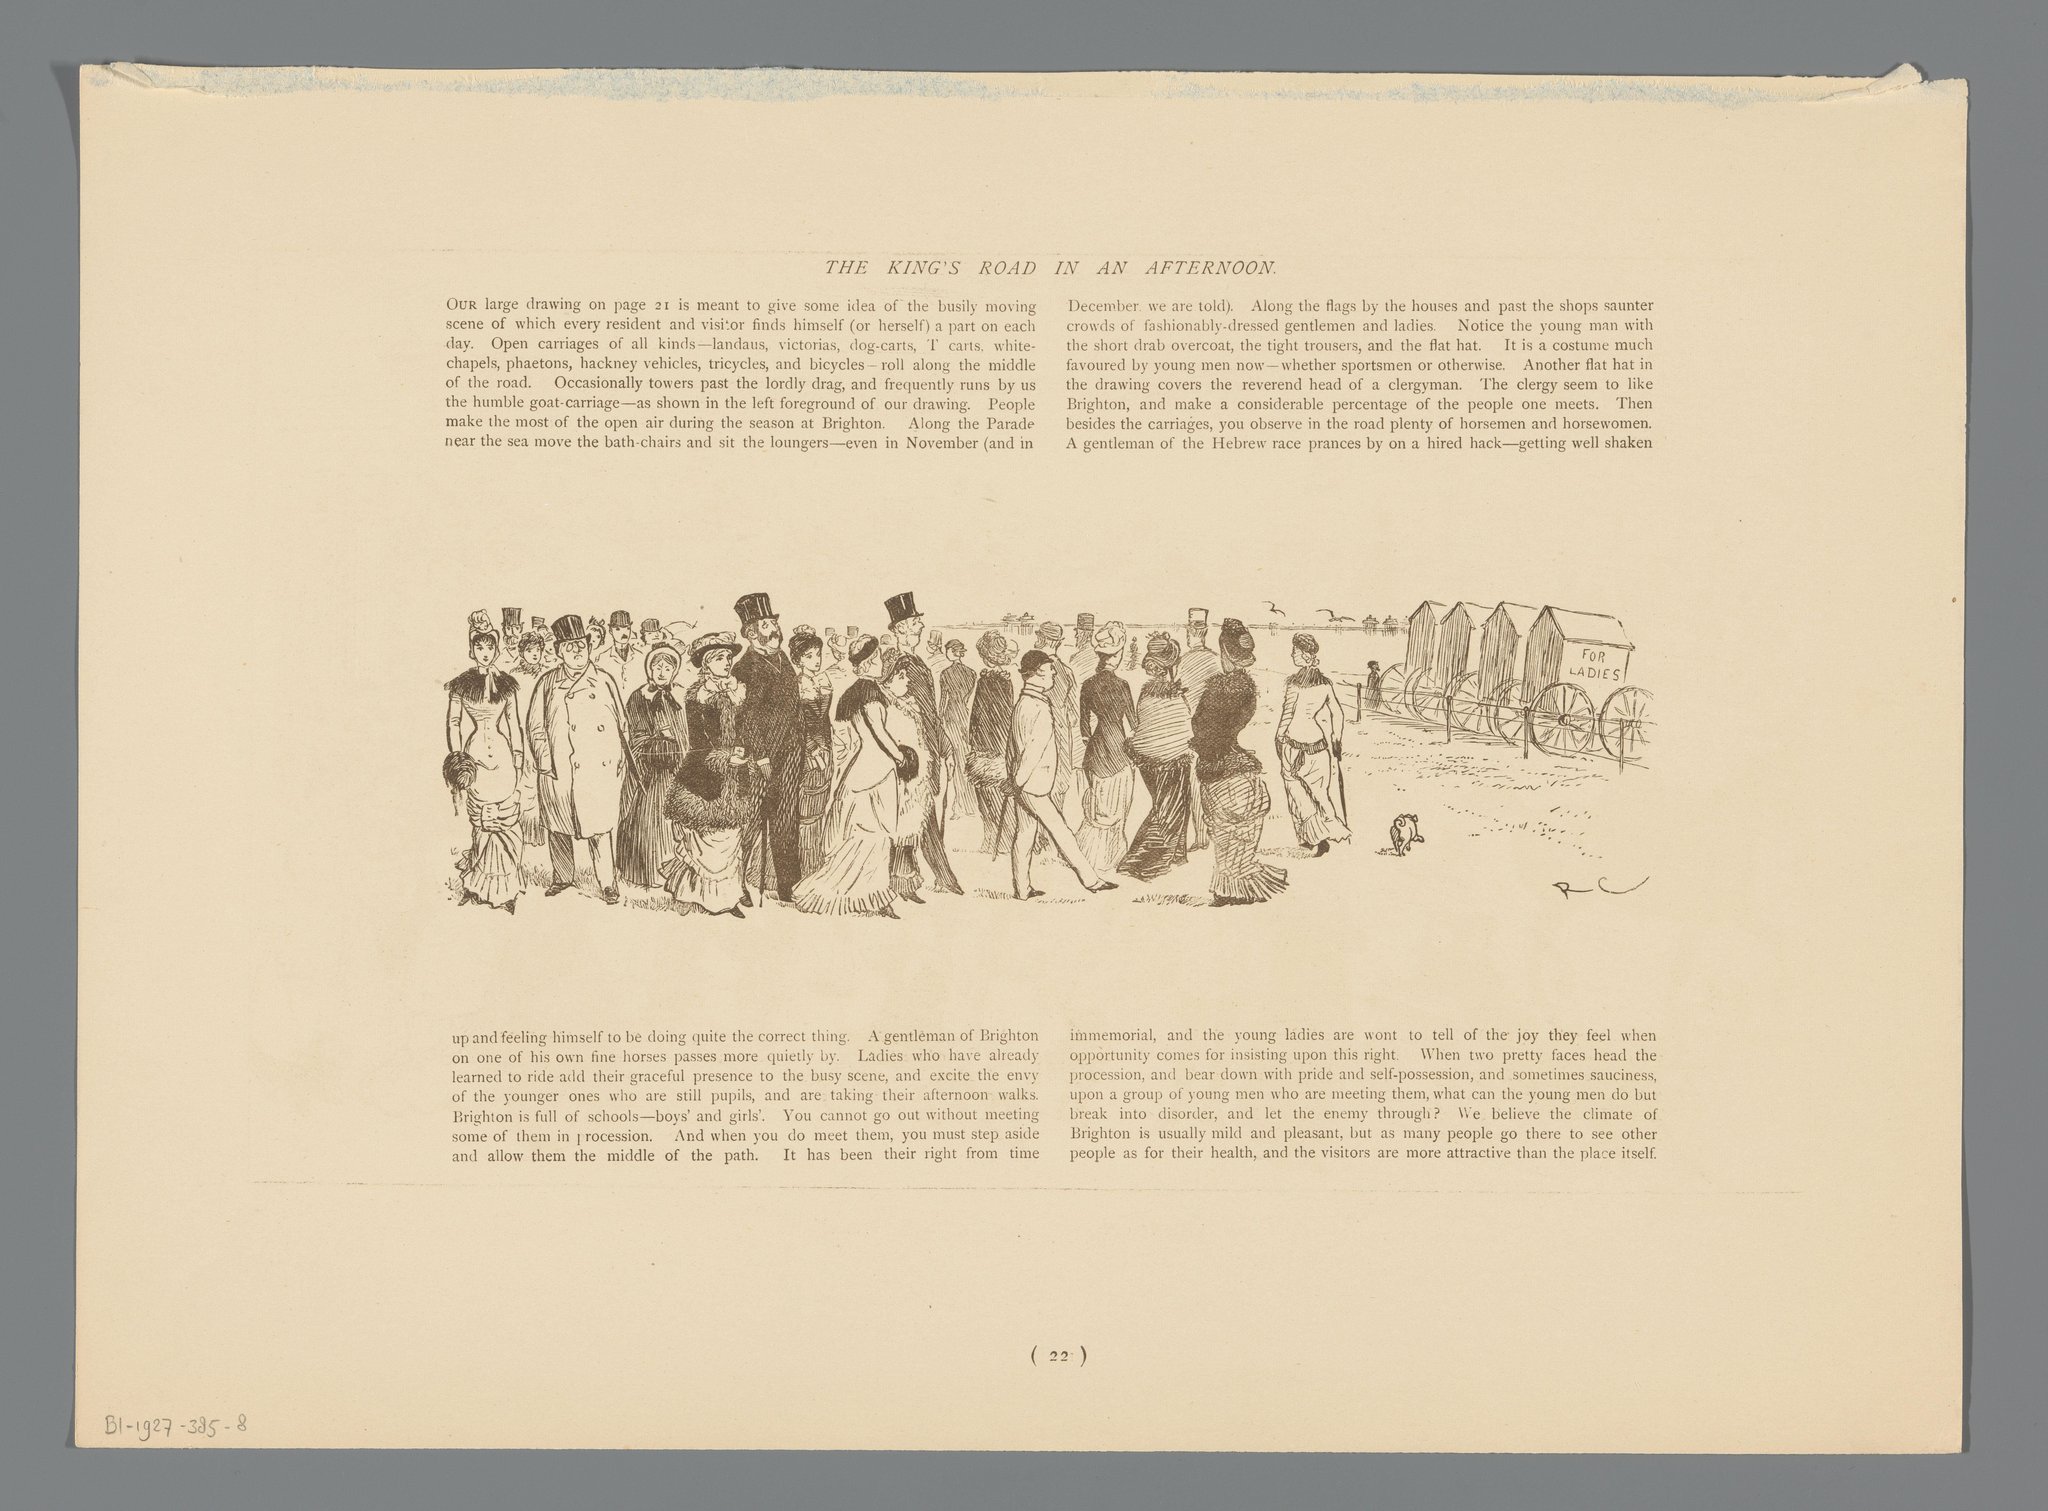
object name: print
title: Groep mensen aan de kust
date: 1889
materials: paper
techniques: letterpress printing, engraving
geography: london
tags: avenue, boulevard, promenade, esplanade, city-view, and landscape with man-made constructions (+ city(-scape) with figures, staffage), coast (+ landscape with figures, staffage)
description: Prent uit: Gleanings from the Graphic. Londen: George Routledge & Sons, 1889. Dit werk is een bundel van diverse illustraties die eerder verschenen in verschillende jaargangen van het Engelse weekblad 'The Graphic'. De bundel is na het overlijden van Randolph Caldecott uitgegeven.